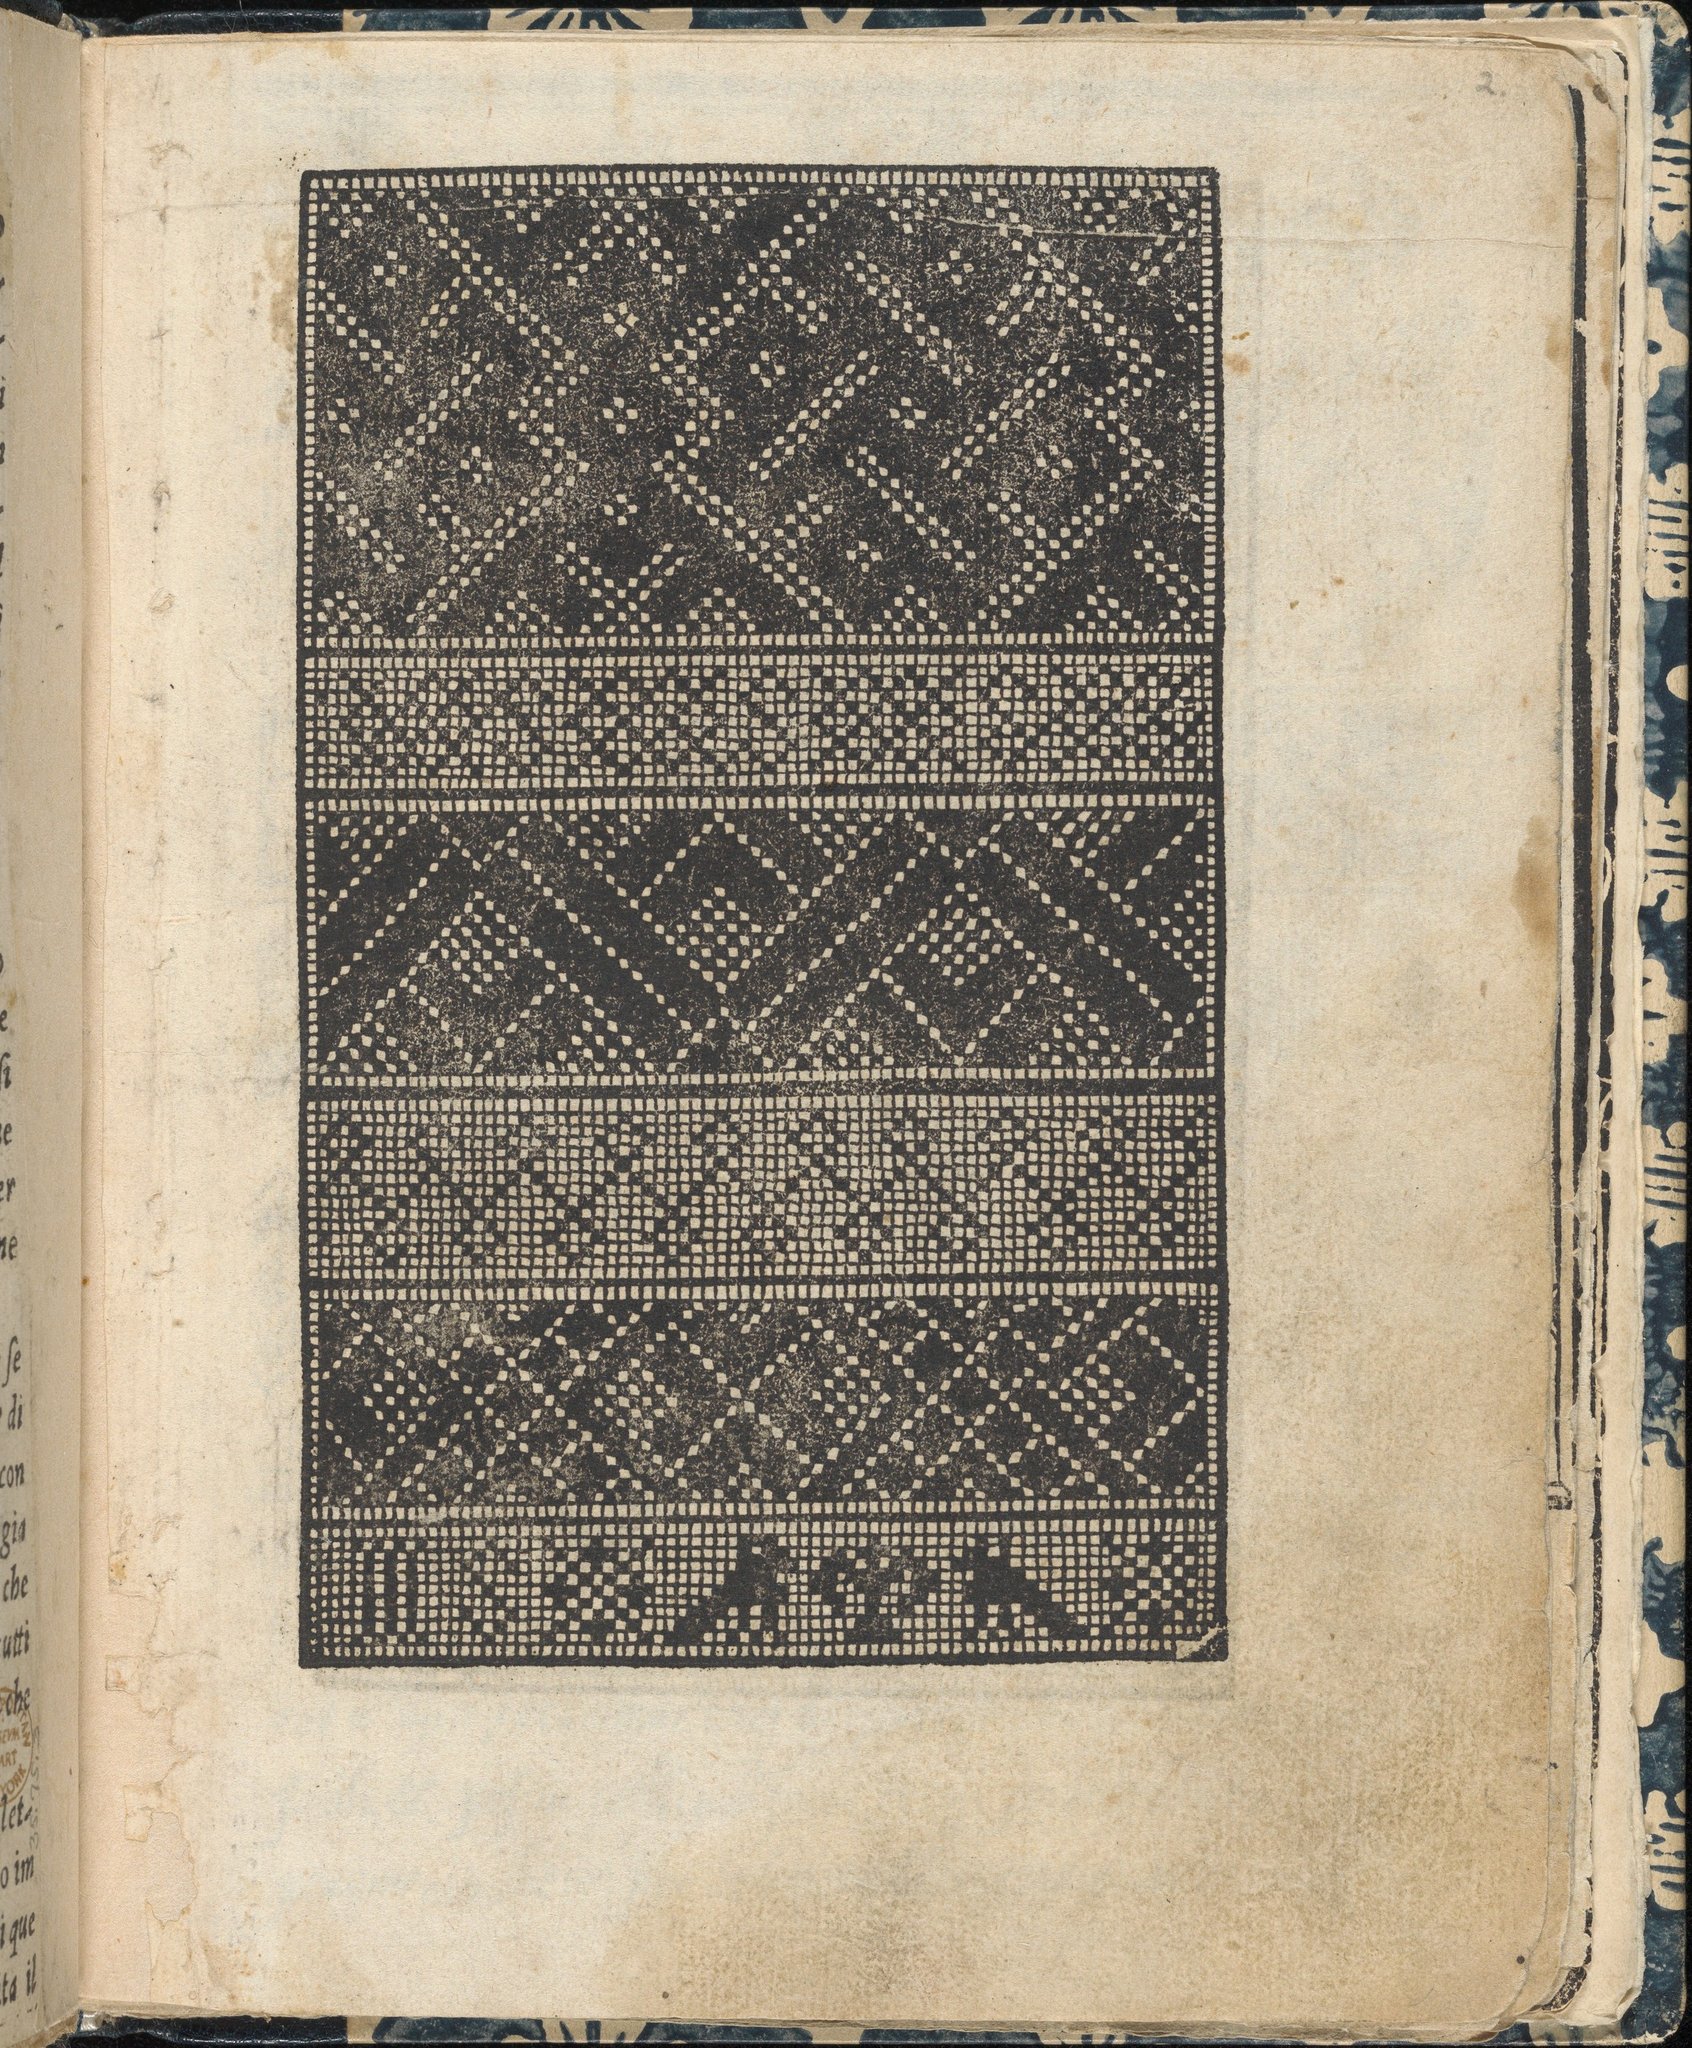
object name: book print ornament architecture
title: Essempio di recammi, page 2 (recto)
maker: giovanni antonio tagliente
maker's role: author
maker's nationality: italian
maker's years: 1465-1528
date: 1530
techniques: woodcut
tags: ornament